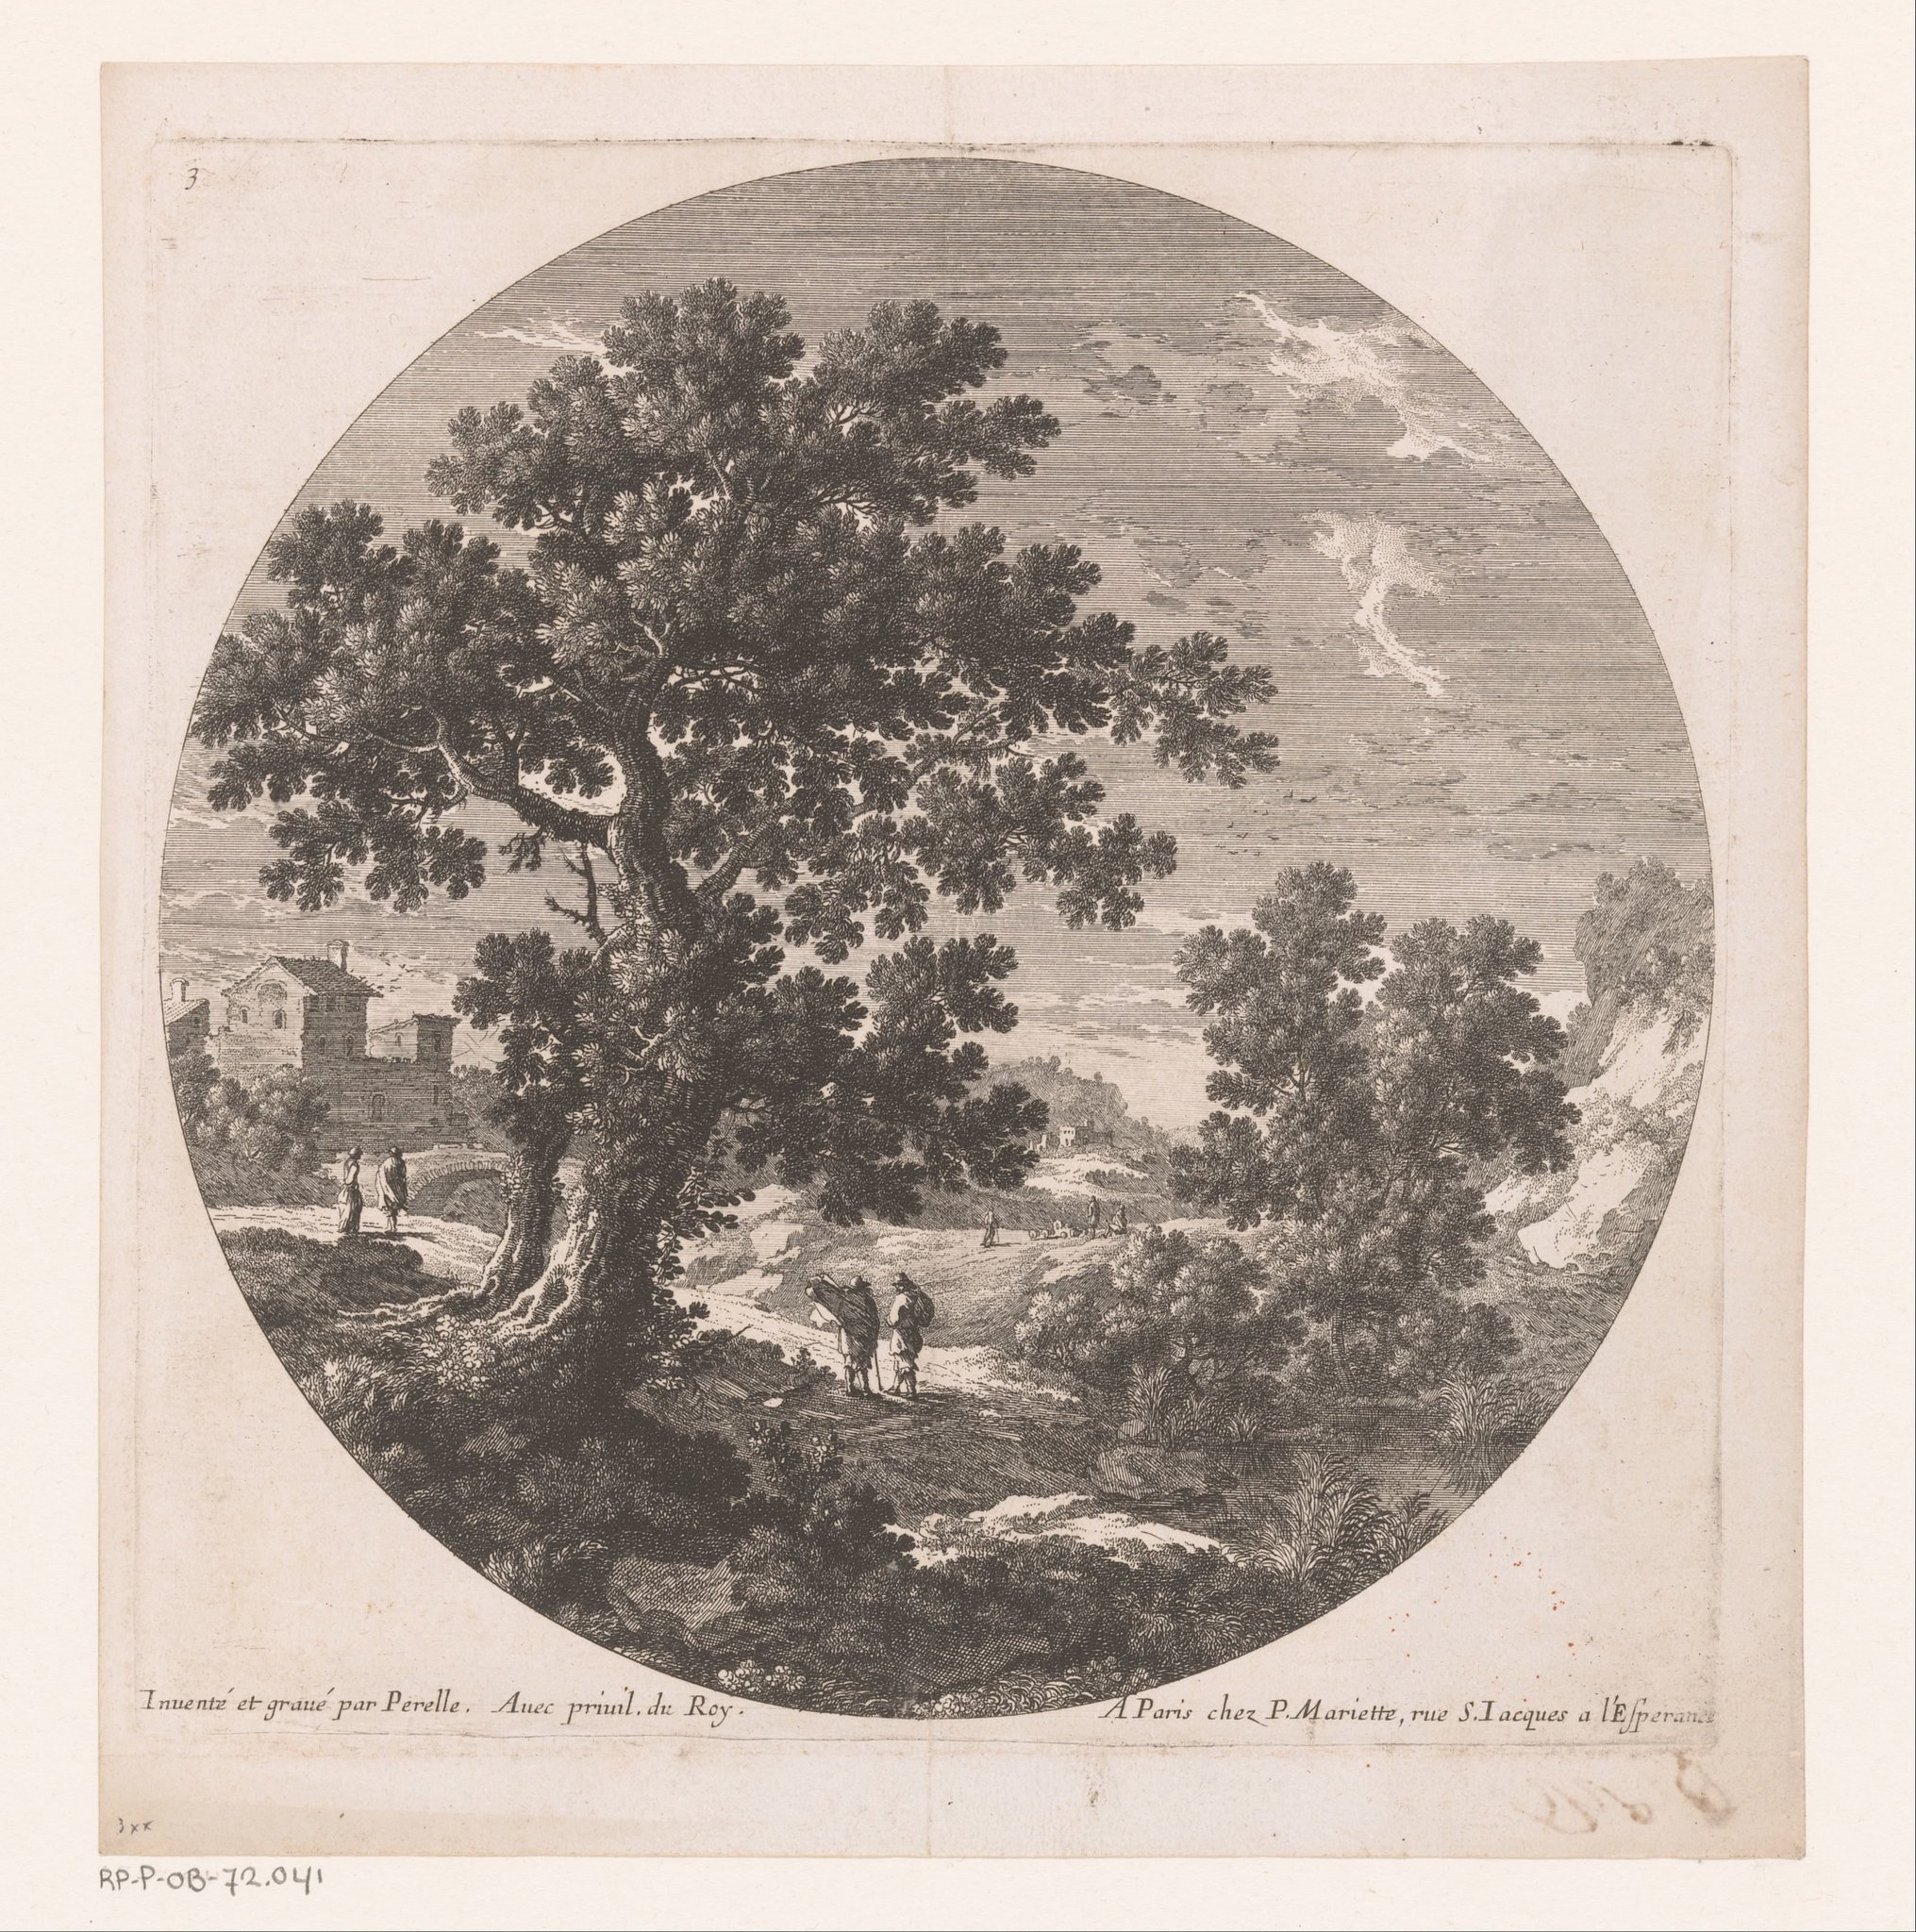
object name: print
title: Landschap met boom en wandelaars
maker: pierre mariette (i)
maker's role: print maker, publisher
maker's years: 1596-1657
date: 1613-1657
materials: paper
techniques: etching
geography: france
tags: landscapes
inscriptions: collector's mark: Lugt 240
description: Prenten met het signatuur 'Perelle' kunnen zowel door vader Gabriel als door zonen Nicolas en Adam gemaakt zijn.